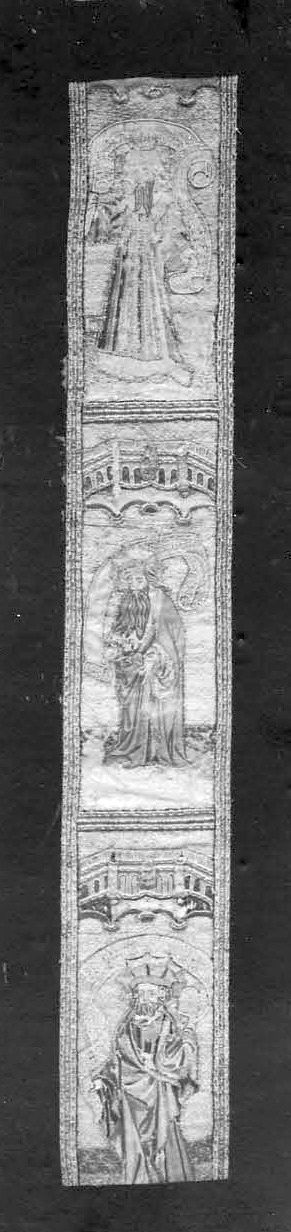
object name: orphrey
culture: spanish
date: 1401-1433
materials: silk, thread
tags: men